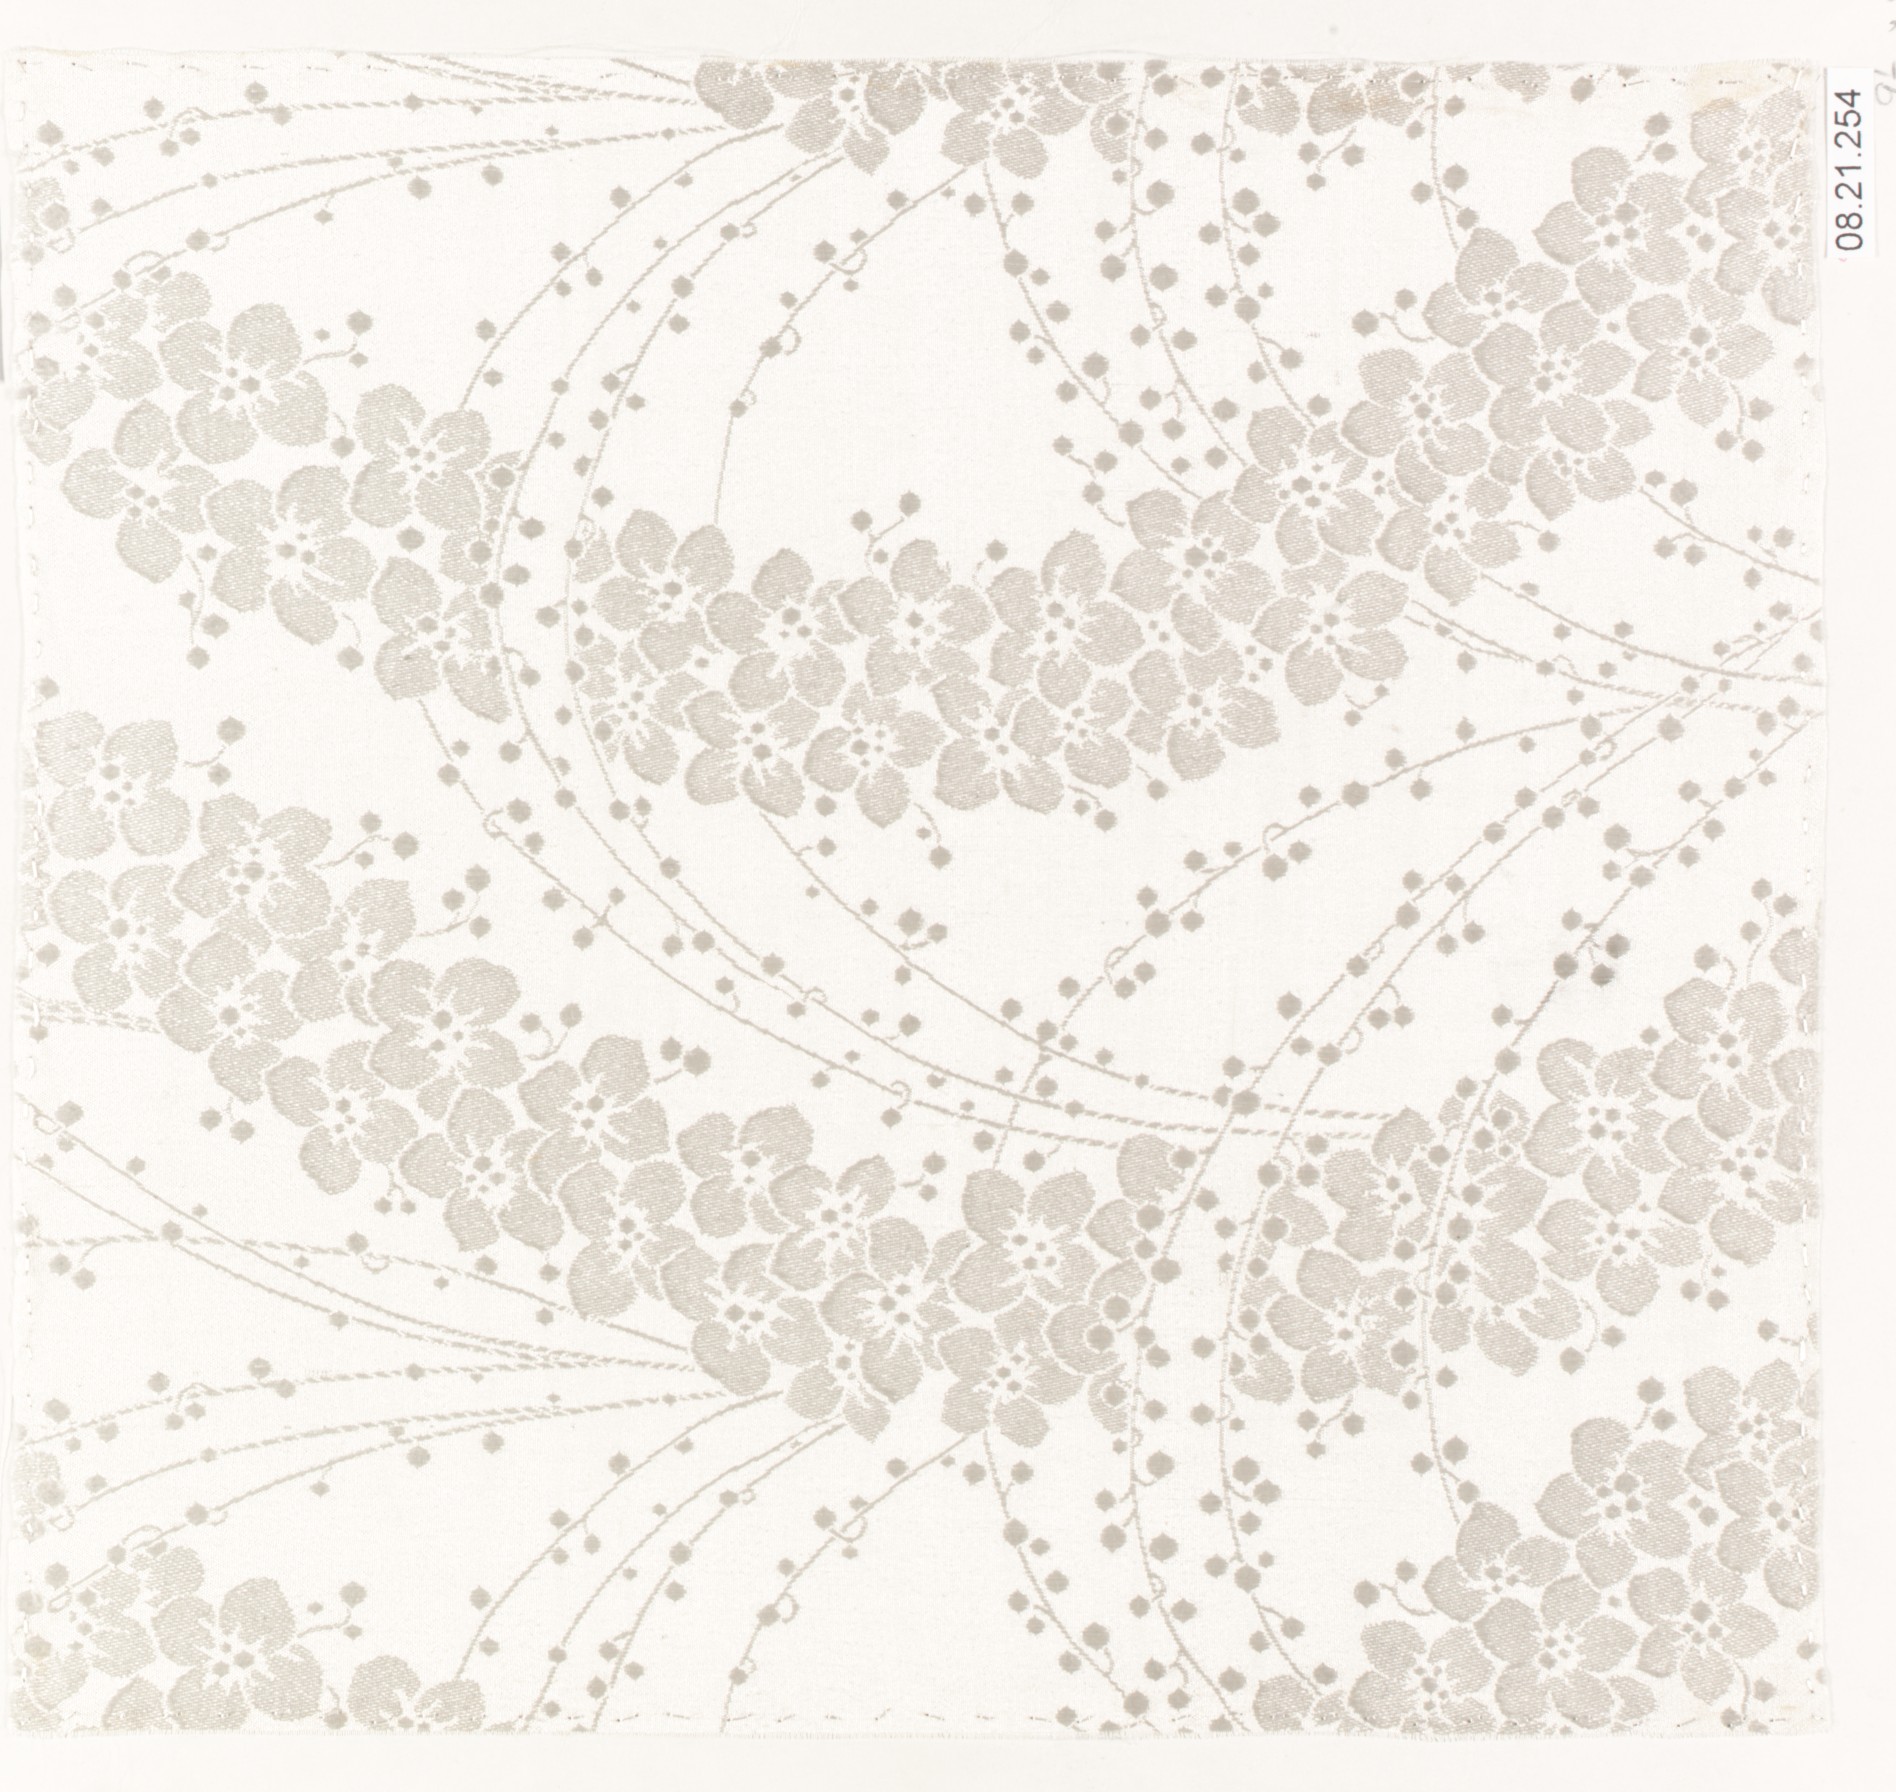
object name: textile sample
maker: Anonymous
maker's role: designer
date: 1900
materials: silk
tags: flowers